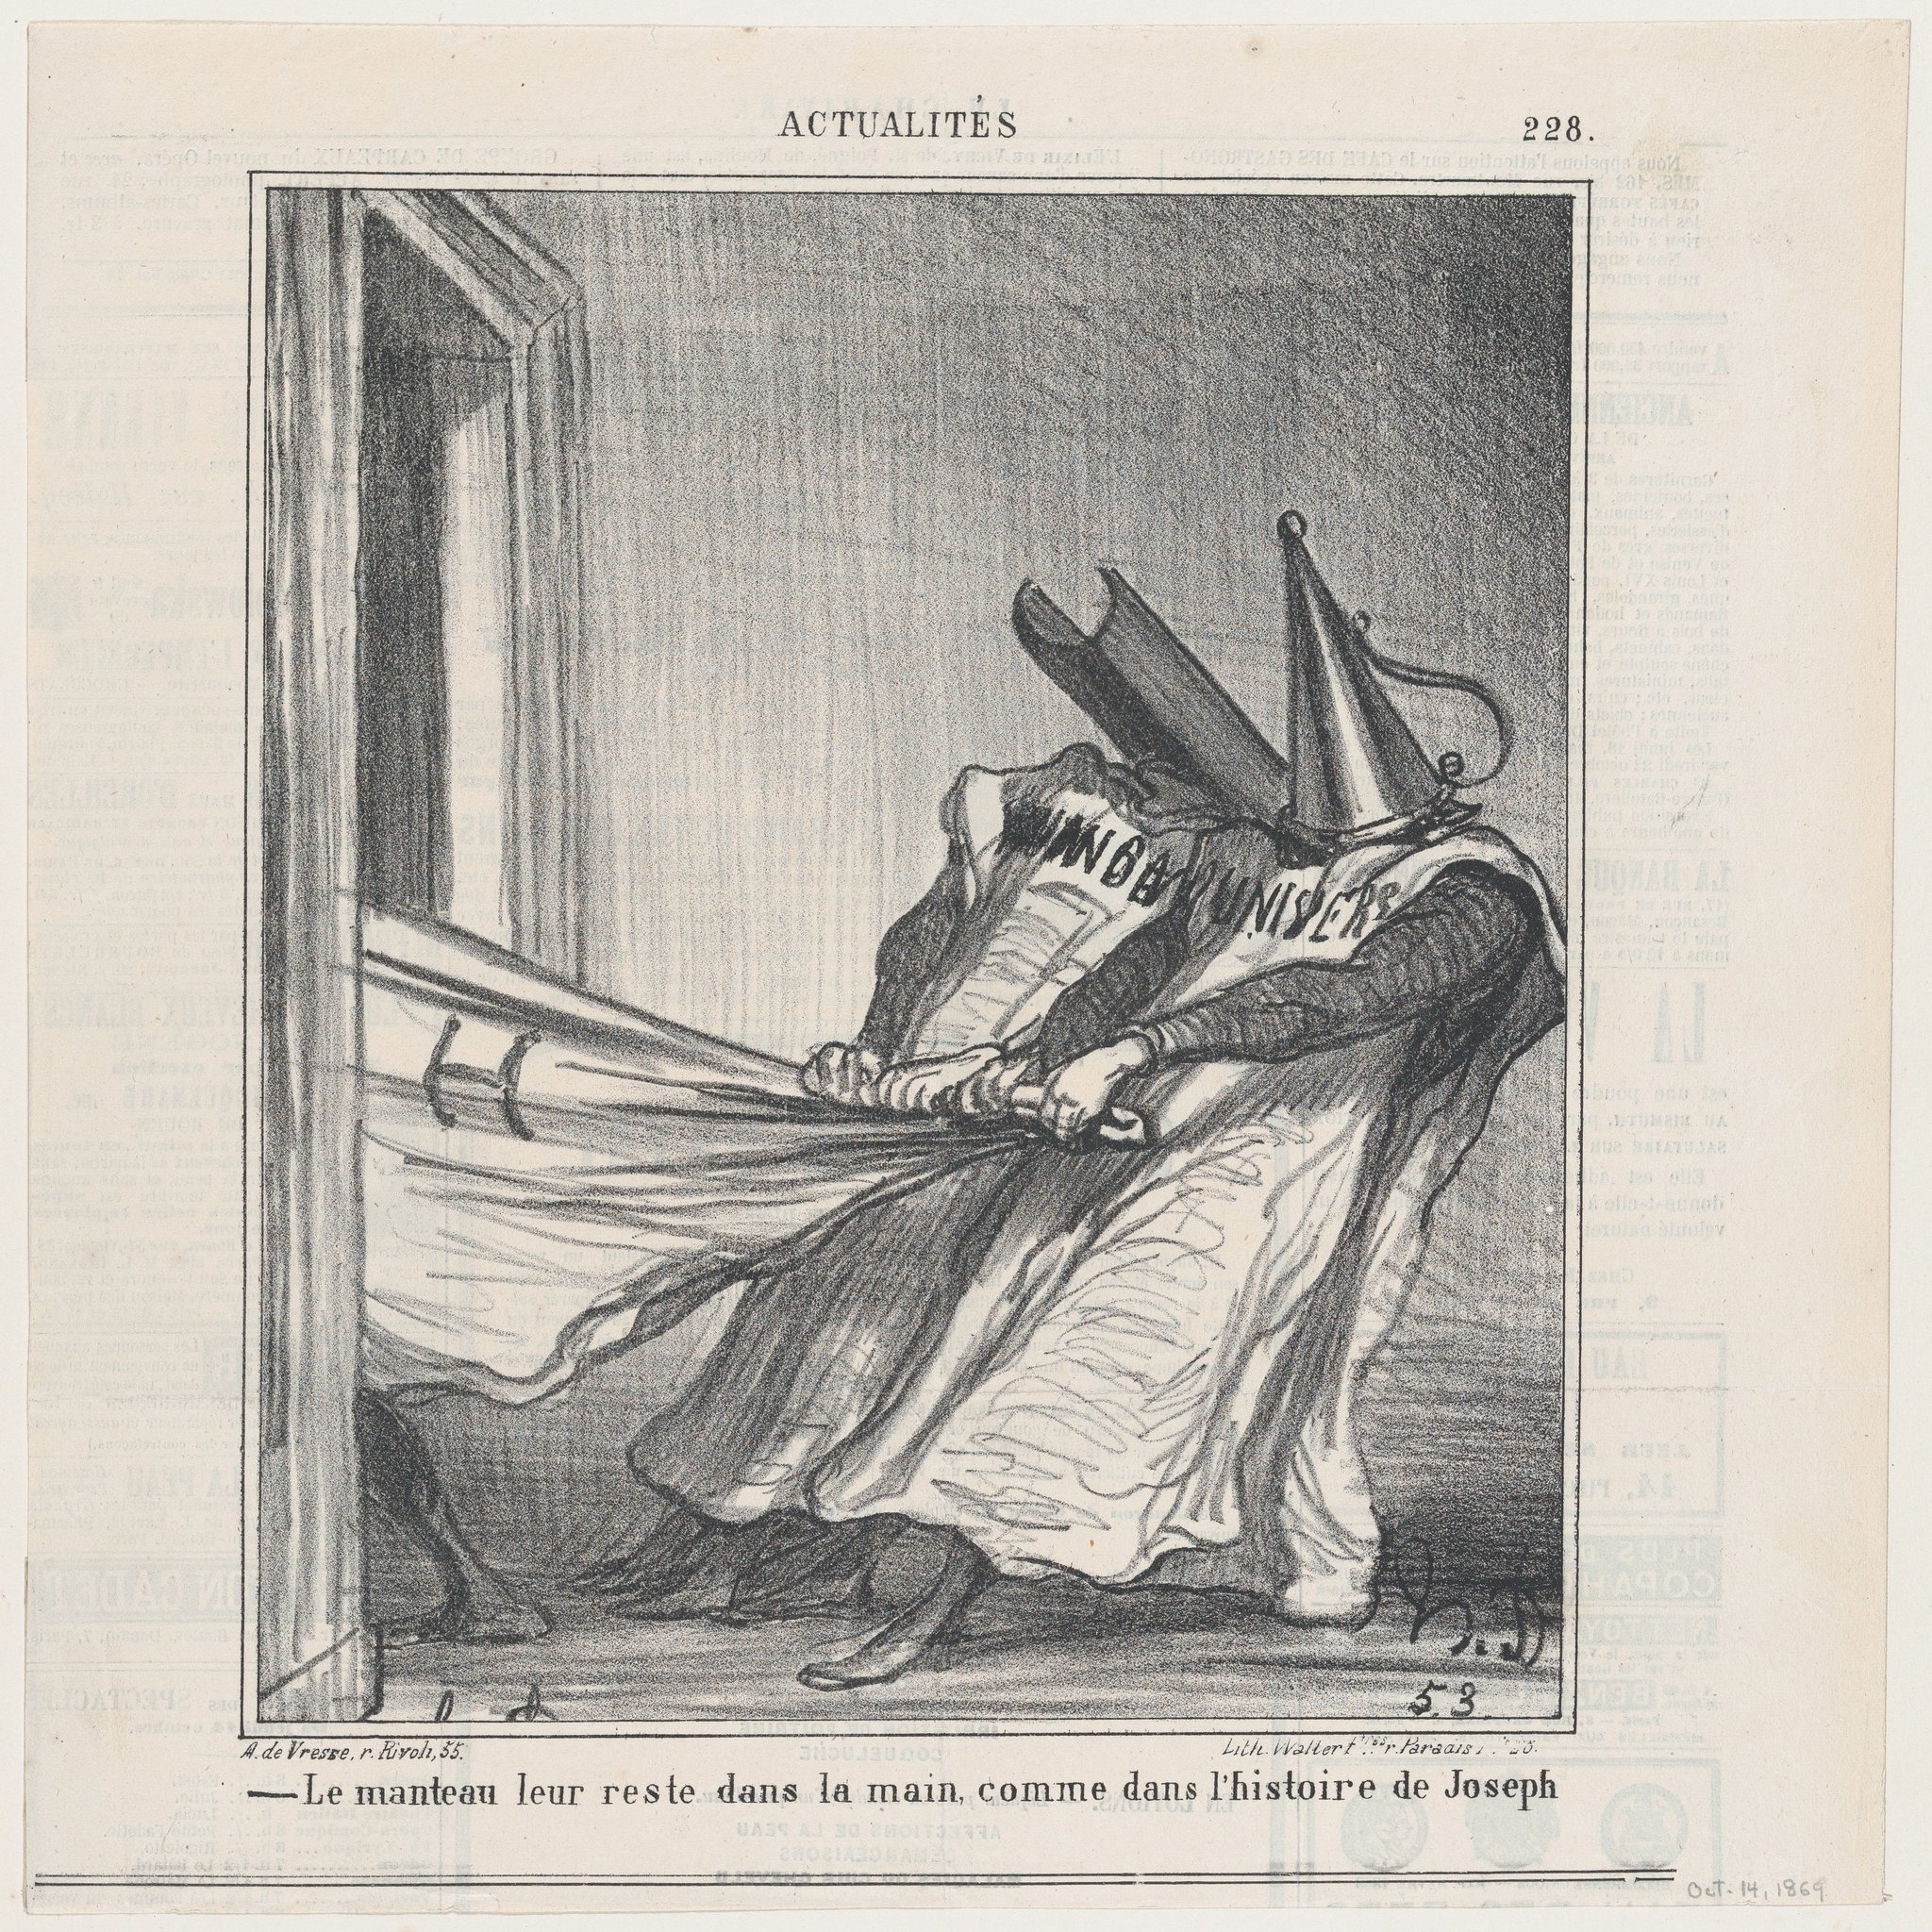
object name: print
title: The cloak remains in their hands, like in the story of Joseph, from 'News of the day,' published in Le Charivari, October 14, 1869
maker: honoré daumier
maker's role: artist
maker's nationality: french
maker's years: 1808-1879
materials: paper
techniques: lithograph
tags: satire